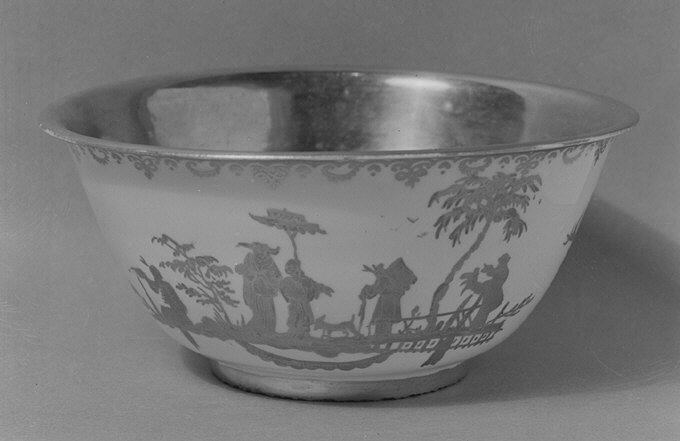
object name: bowl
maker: meissen manufactory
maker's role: manufactory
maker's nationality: german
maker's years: 1710-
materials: hard paste porcelain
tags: human figures,chinoiserie